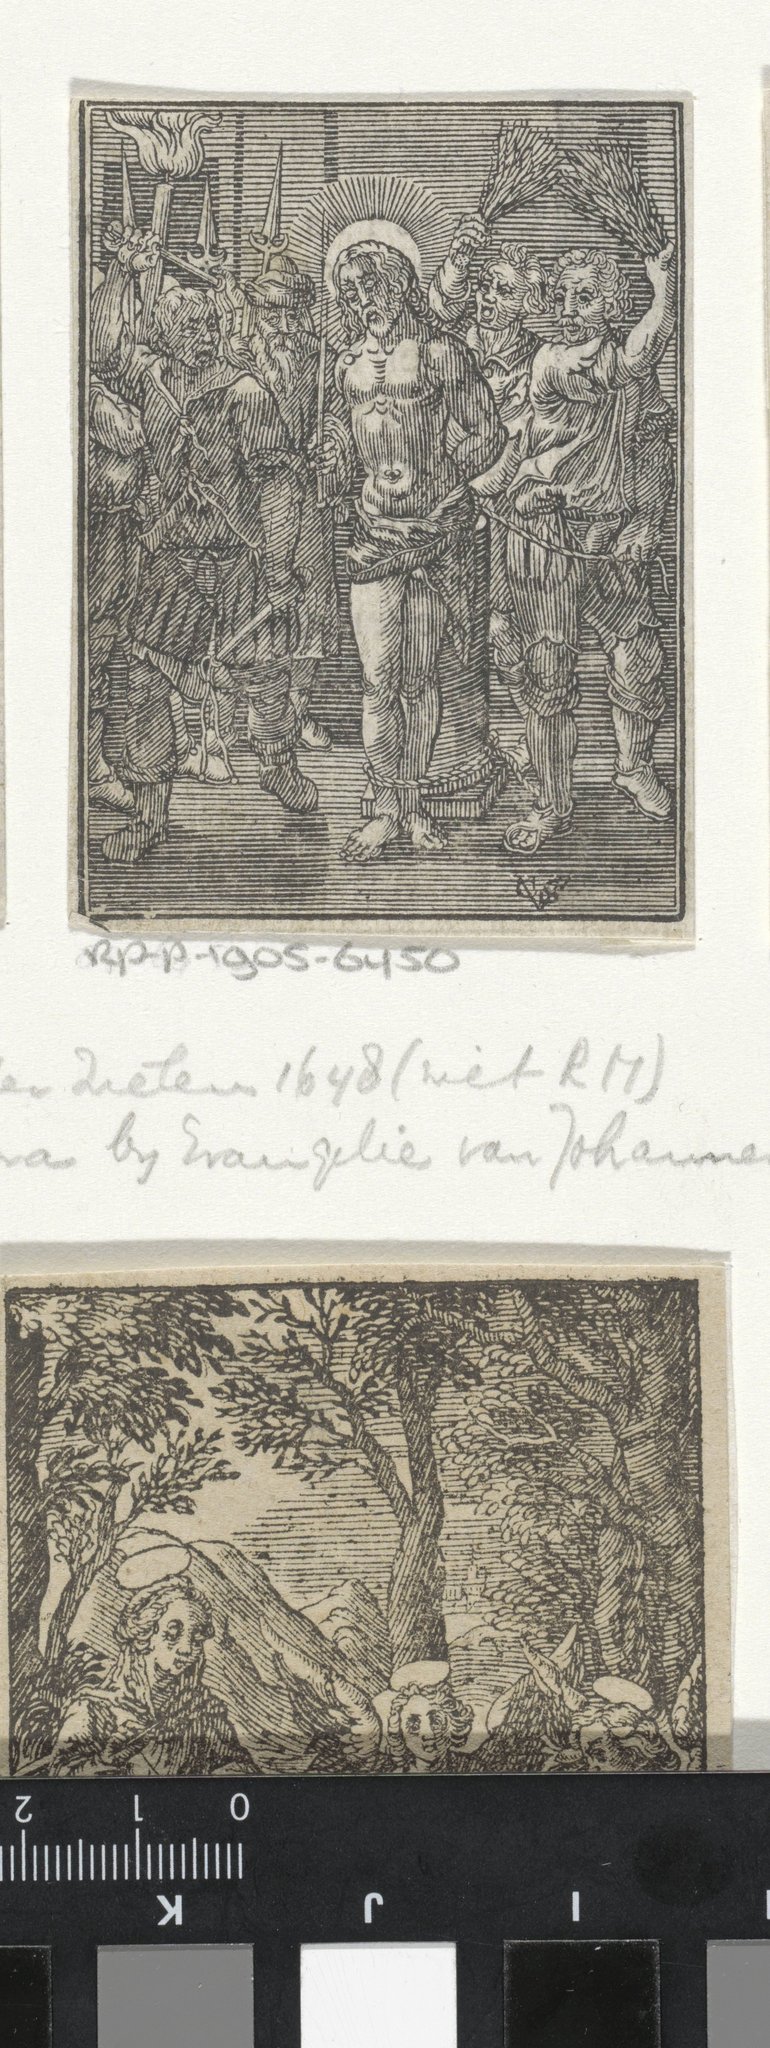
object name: print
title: Geseling van Christus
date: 1648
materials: paper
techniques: letterpress printing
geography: amsterdam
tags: flagellation by soldiers, christ usually tied to a column (matthew 27:26; mark 15:15; john 19:1)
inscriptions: collector's mark: Lugt 2228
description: Prent uit: Sichem, Christoffel van (II). 'tSchat der zielen, dat is: Het geheele leven ons Heeren Iesu Christi. Amsterdam: Pieter Jacobsz. Paets, 1648. Prent uit: Biblia sacra dat is De geheele Heylighe Schrifture bedeylt in 't Out en Nieu Testament. Amsterdam: Pieter Jacobsz. Paets, 1657.